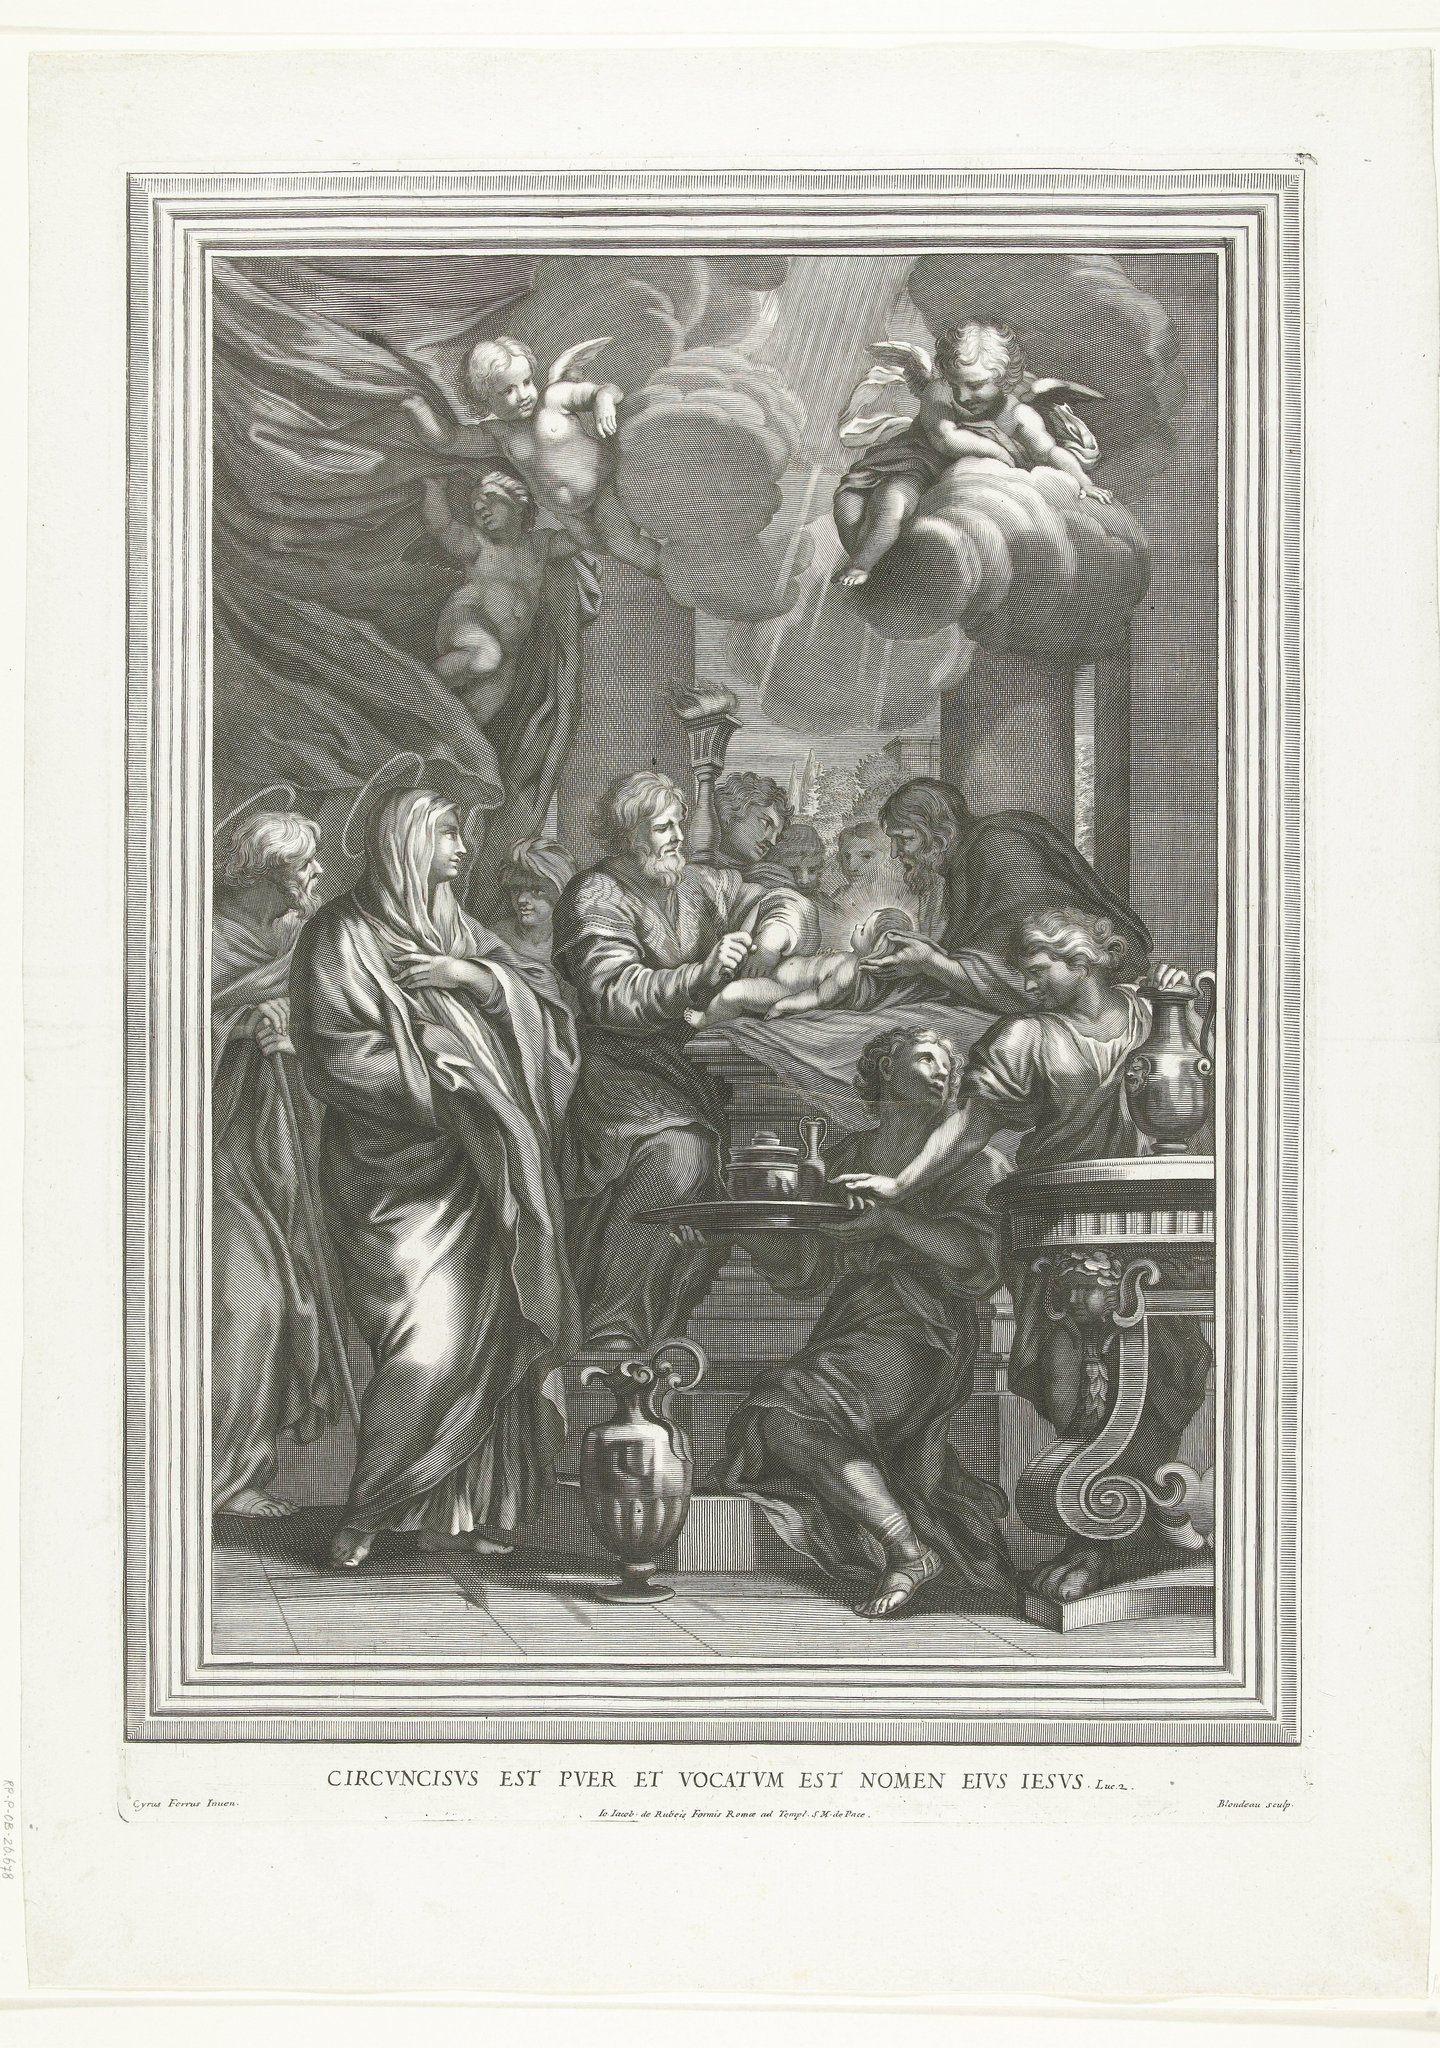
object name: print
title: Circvncisvs est pver et vocatvm est nomen eivs iesvs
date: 1665-1698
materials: paper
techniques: engraving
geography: rome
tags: circumcision of the christ-child by the priest in the temple (luke 2:21)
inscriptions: collector's mark: Lugt 240